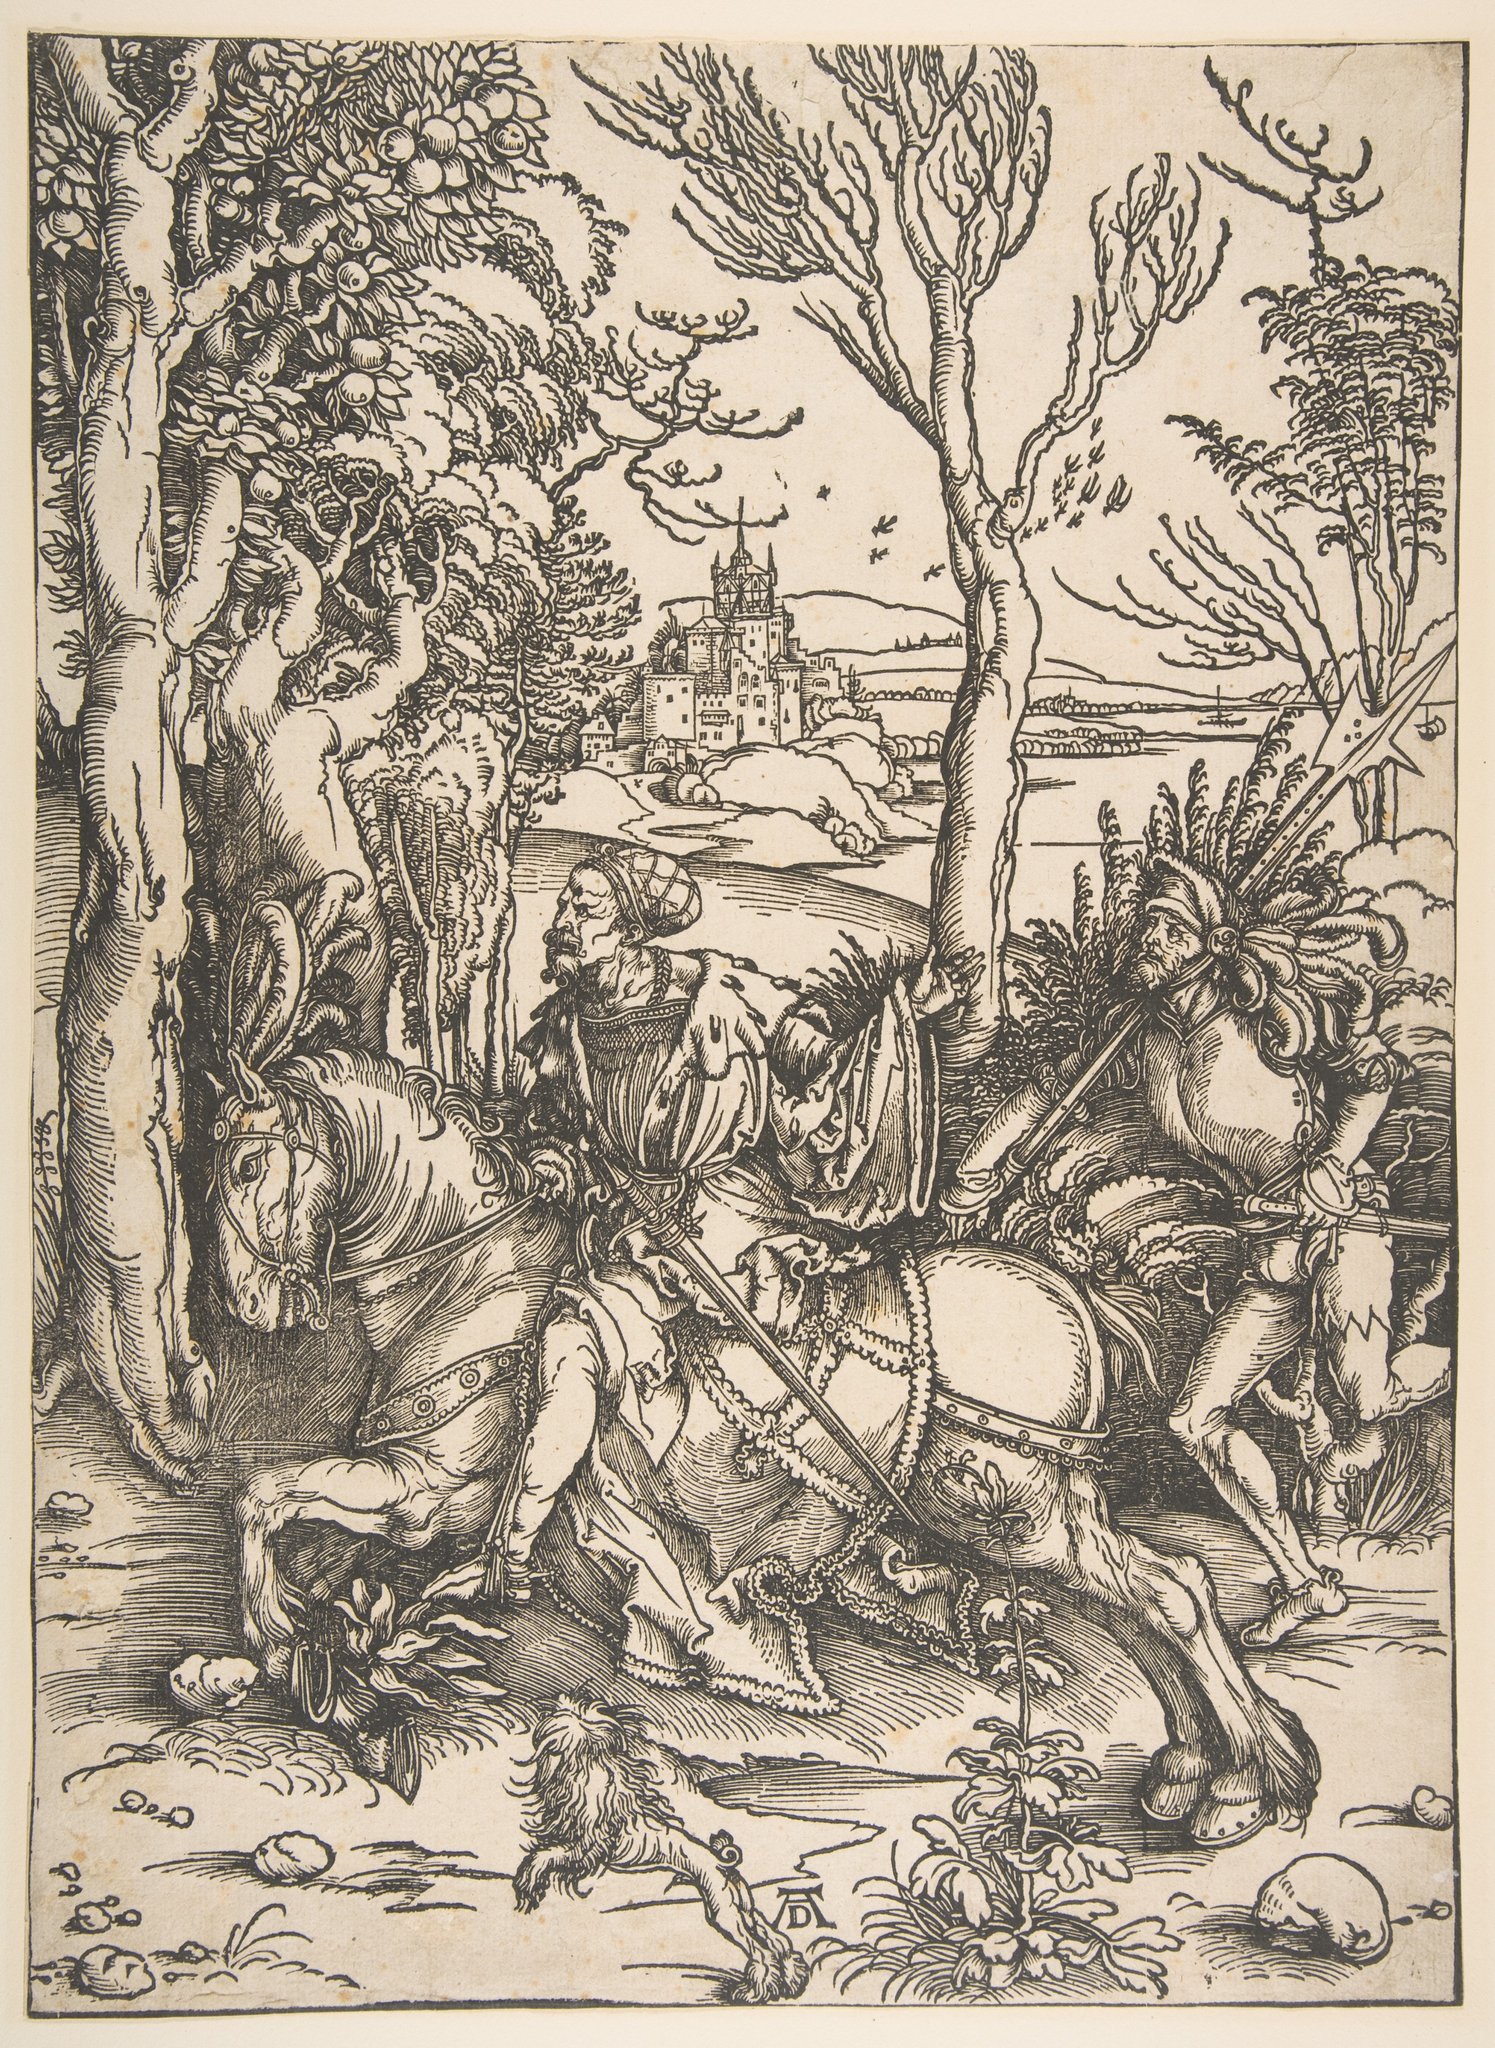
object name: print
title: The Knight and Man-at-Arms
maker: albrecht dürer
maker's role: artist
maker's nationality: german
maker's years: 1471-1528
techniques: woodcut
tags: weapons,swords,men,horses,knights